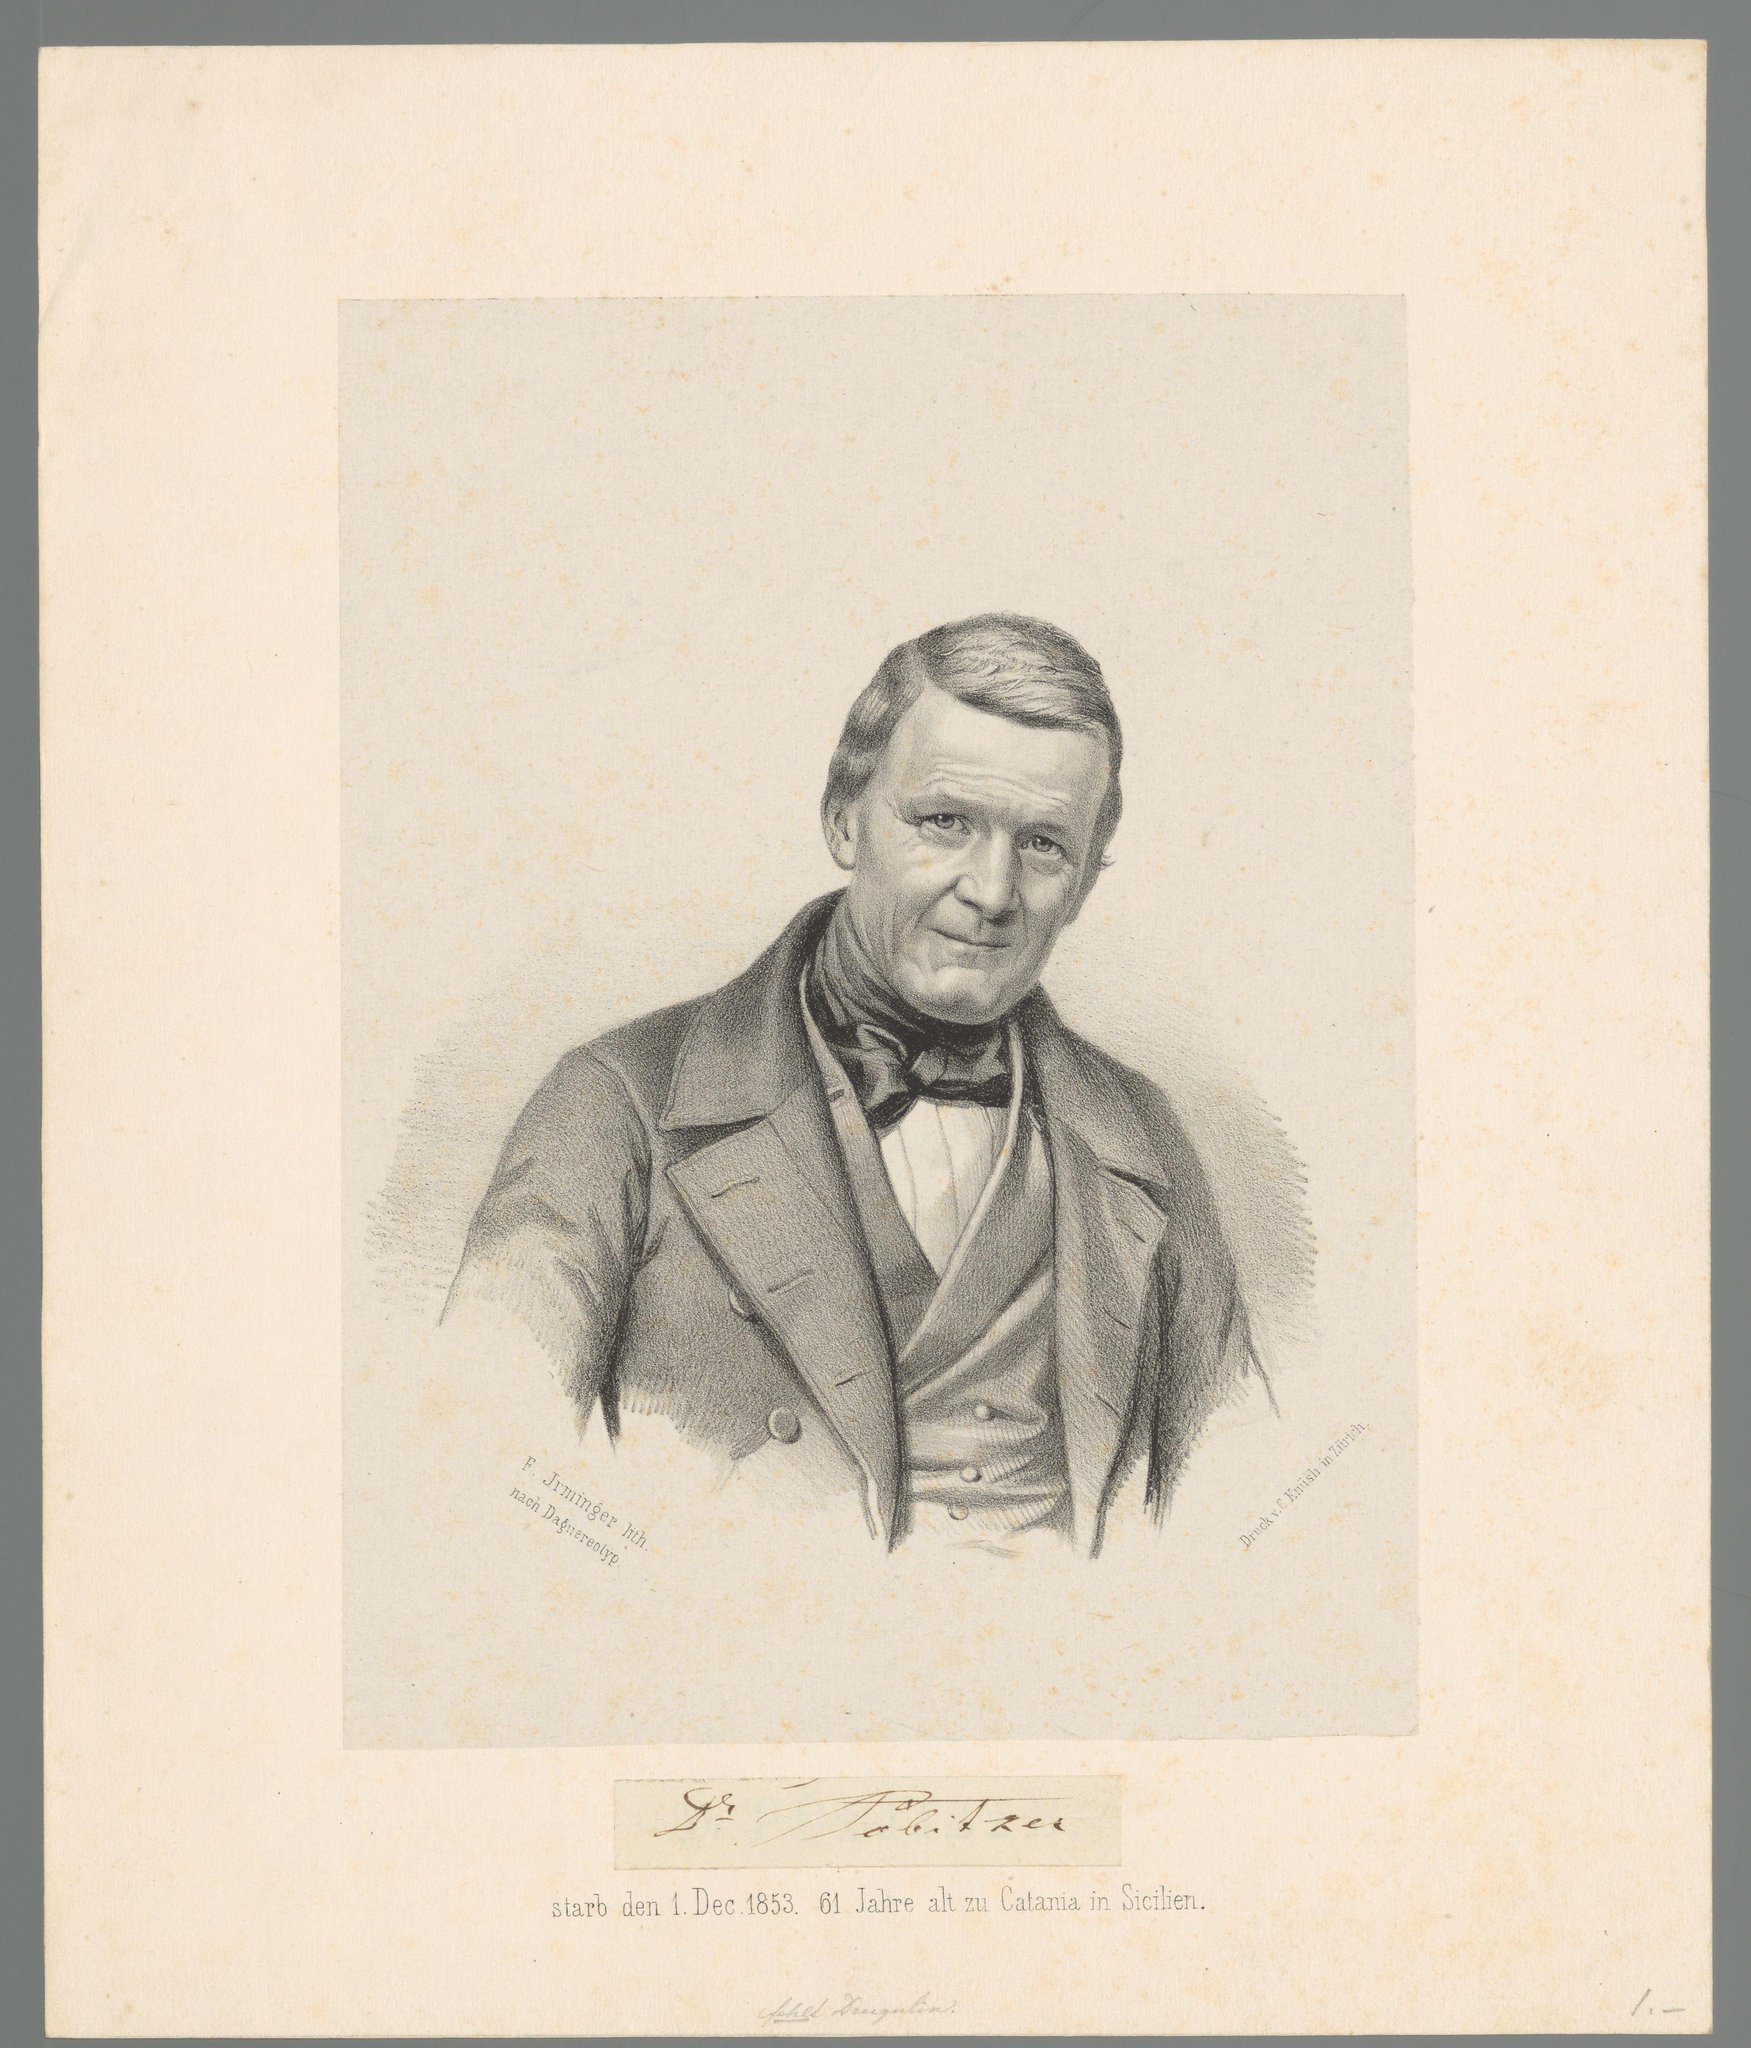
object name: print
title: Portret van een onbekende man, mogelijk Pobitzer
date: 1853-1863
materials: paper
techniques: lithograph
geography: zurich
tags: adult man, historical persons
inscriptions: collector's mark: Lugt 2228, label, label